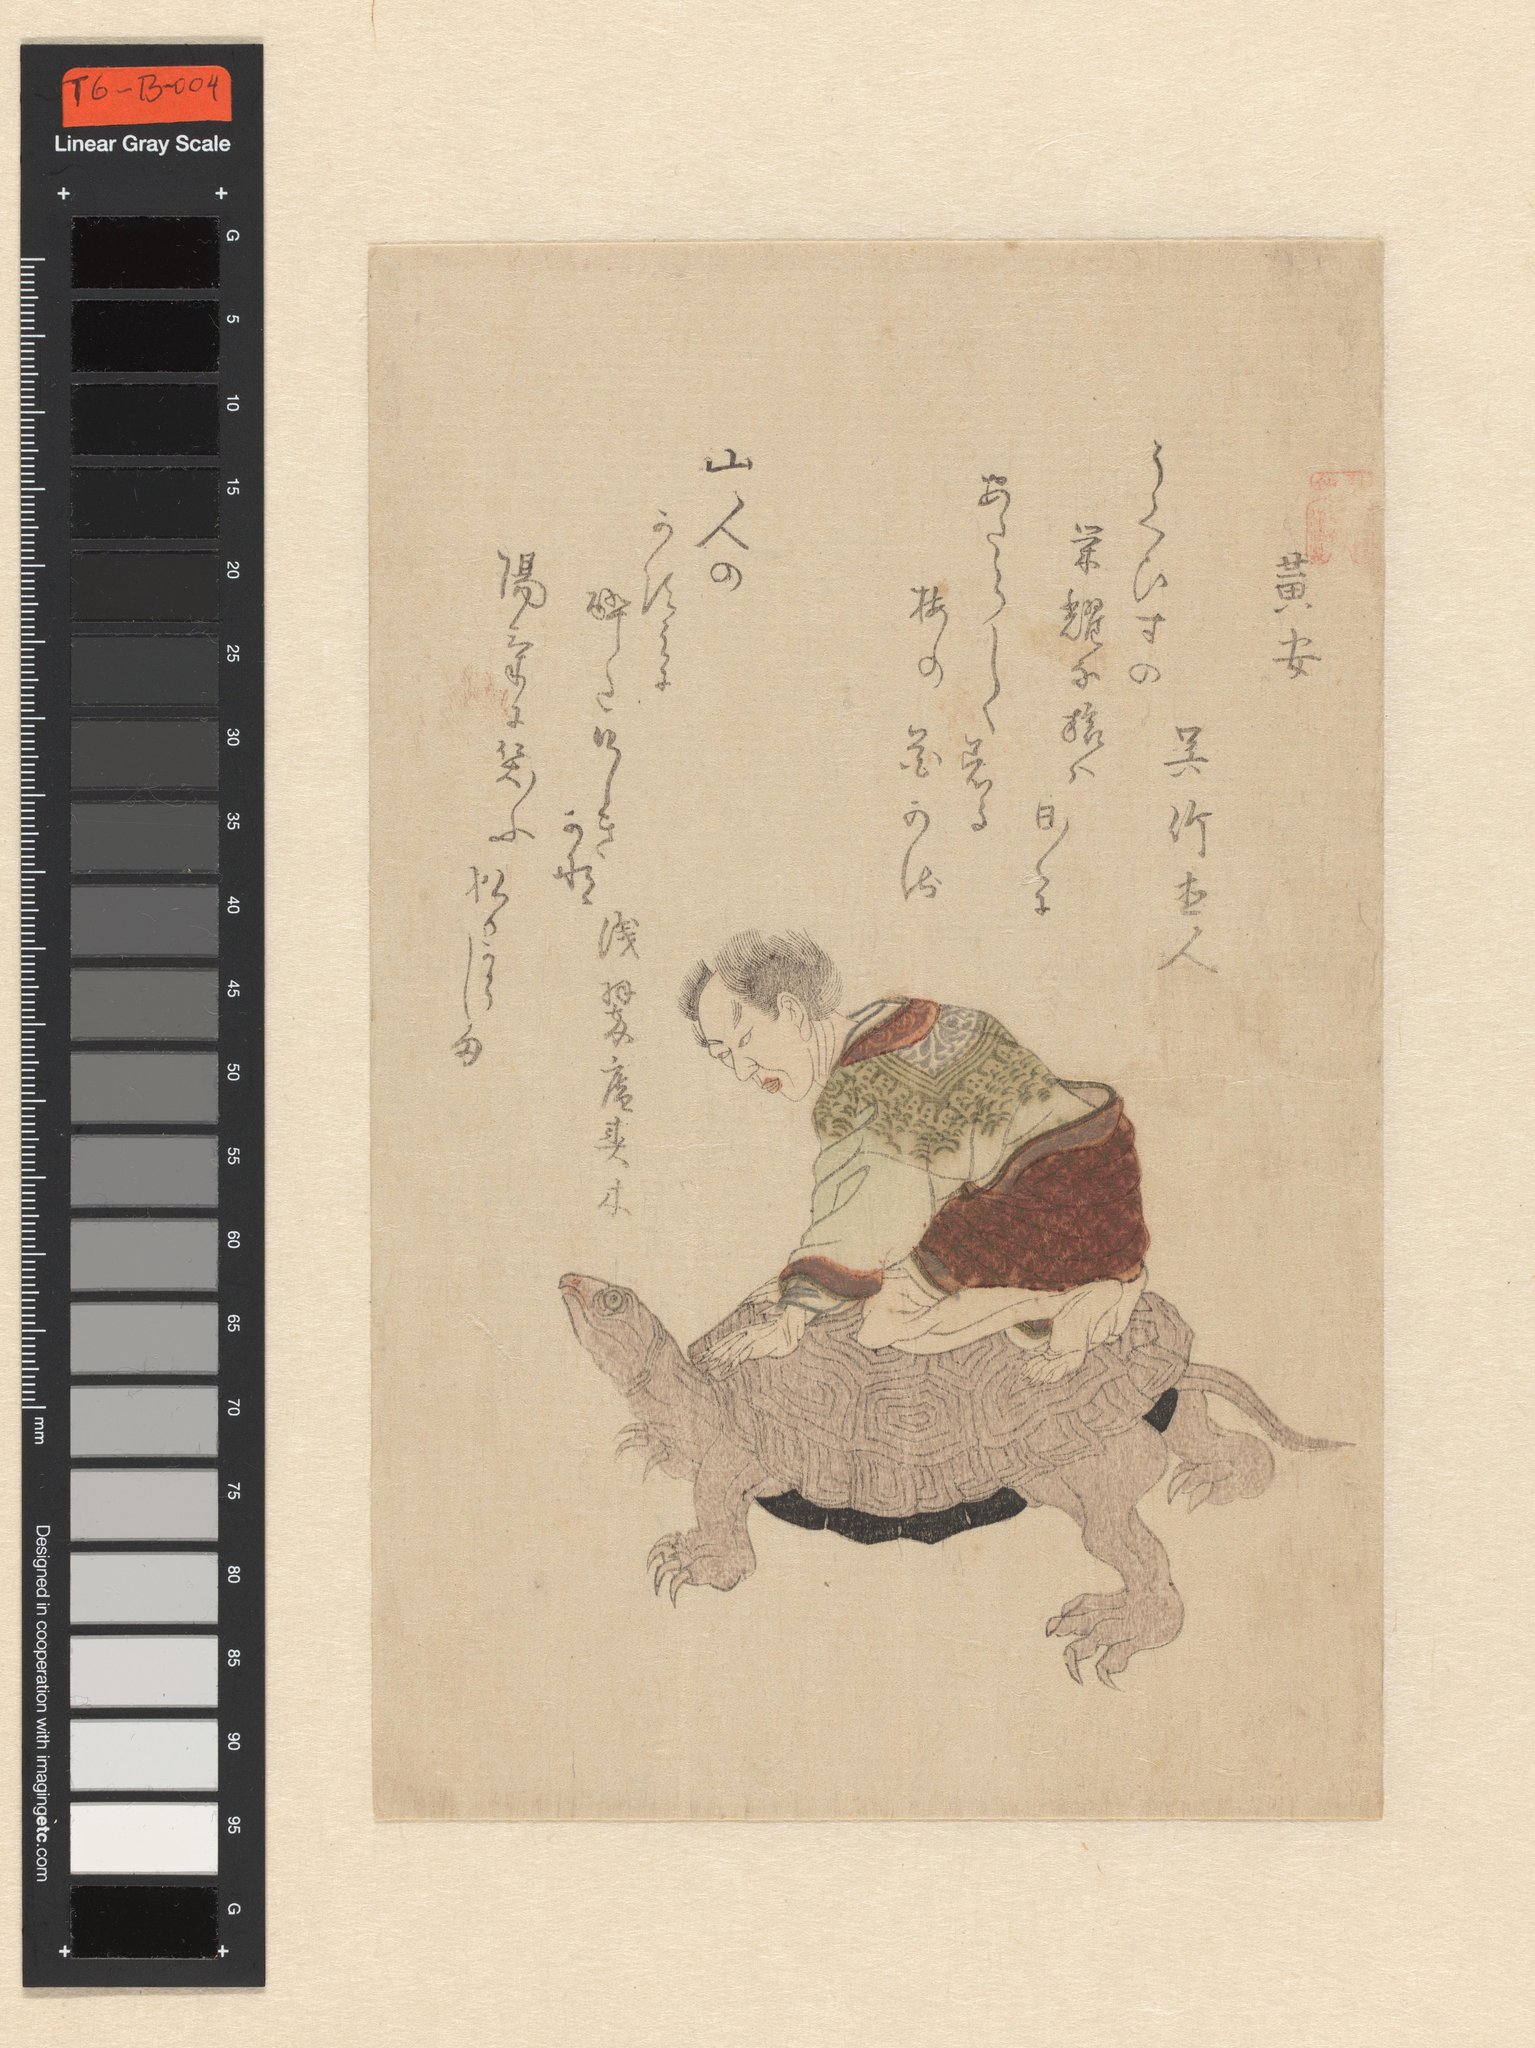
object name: surimono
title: Schildpad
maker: totoya hokkei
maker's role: print maker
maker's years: 1790-1850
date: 1820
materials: paper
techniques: woodcut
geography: japan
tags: tortoises, turtles, riding on animal other than horse, ass, or mule